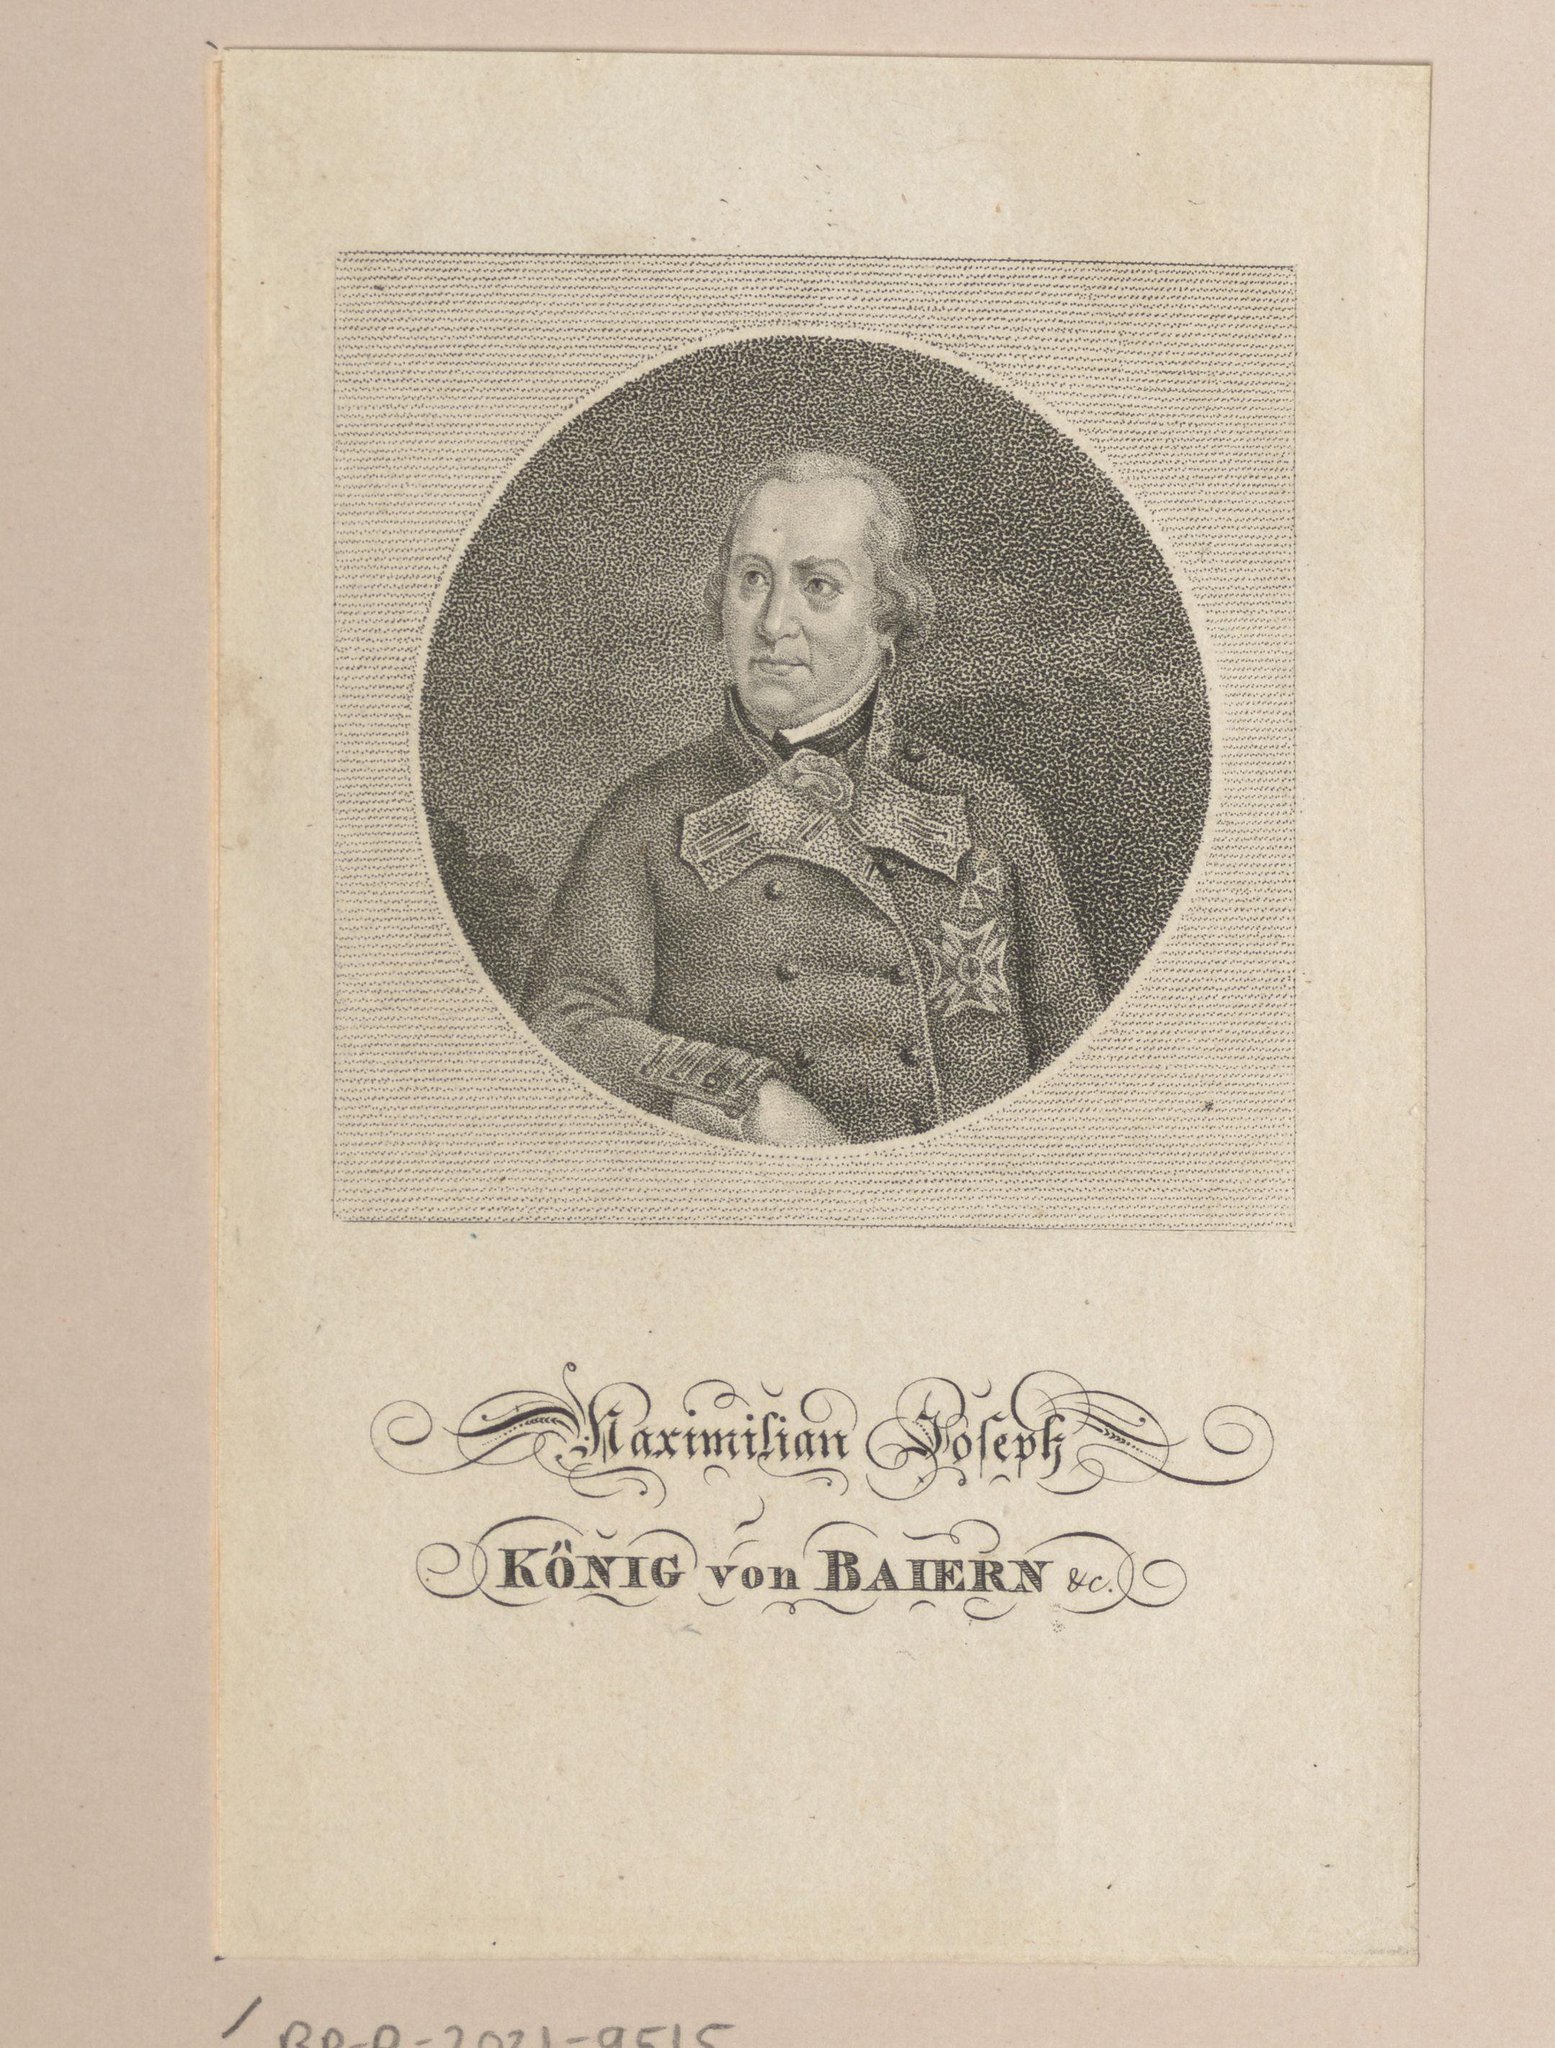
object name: print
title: Portret van Maximiliaan I Jozef van Beieren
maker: Anonymous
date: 1806-1825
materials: paper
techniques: stippling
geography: germany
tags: maximiliaan i jozef (koning van beieren), historical persons, king